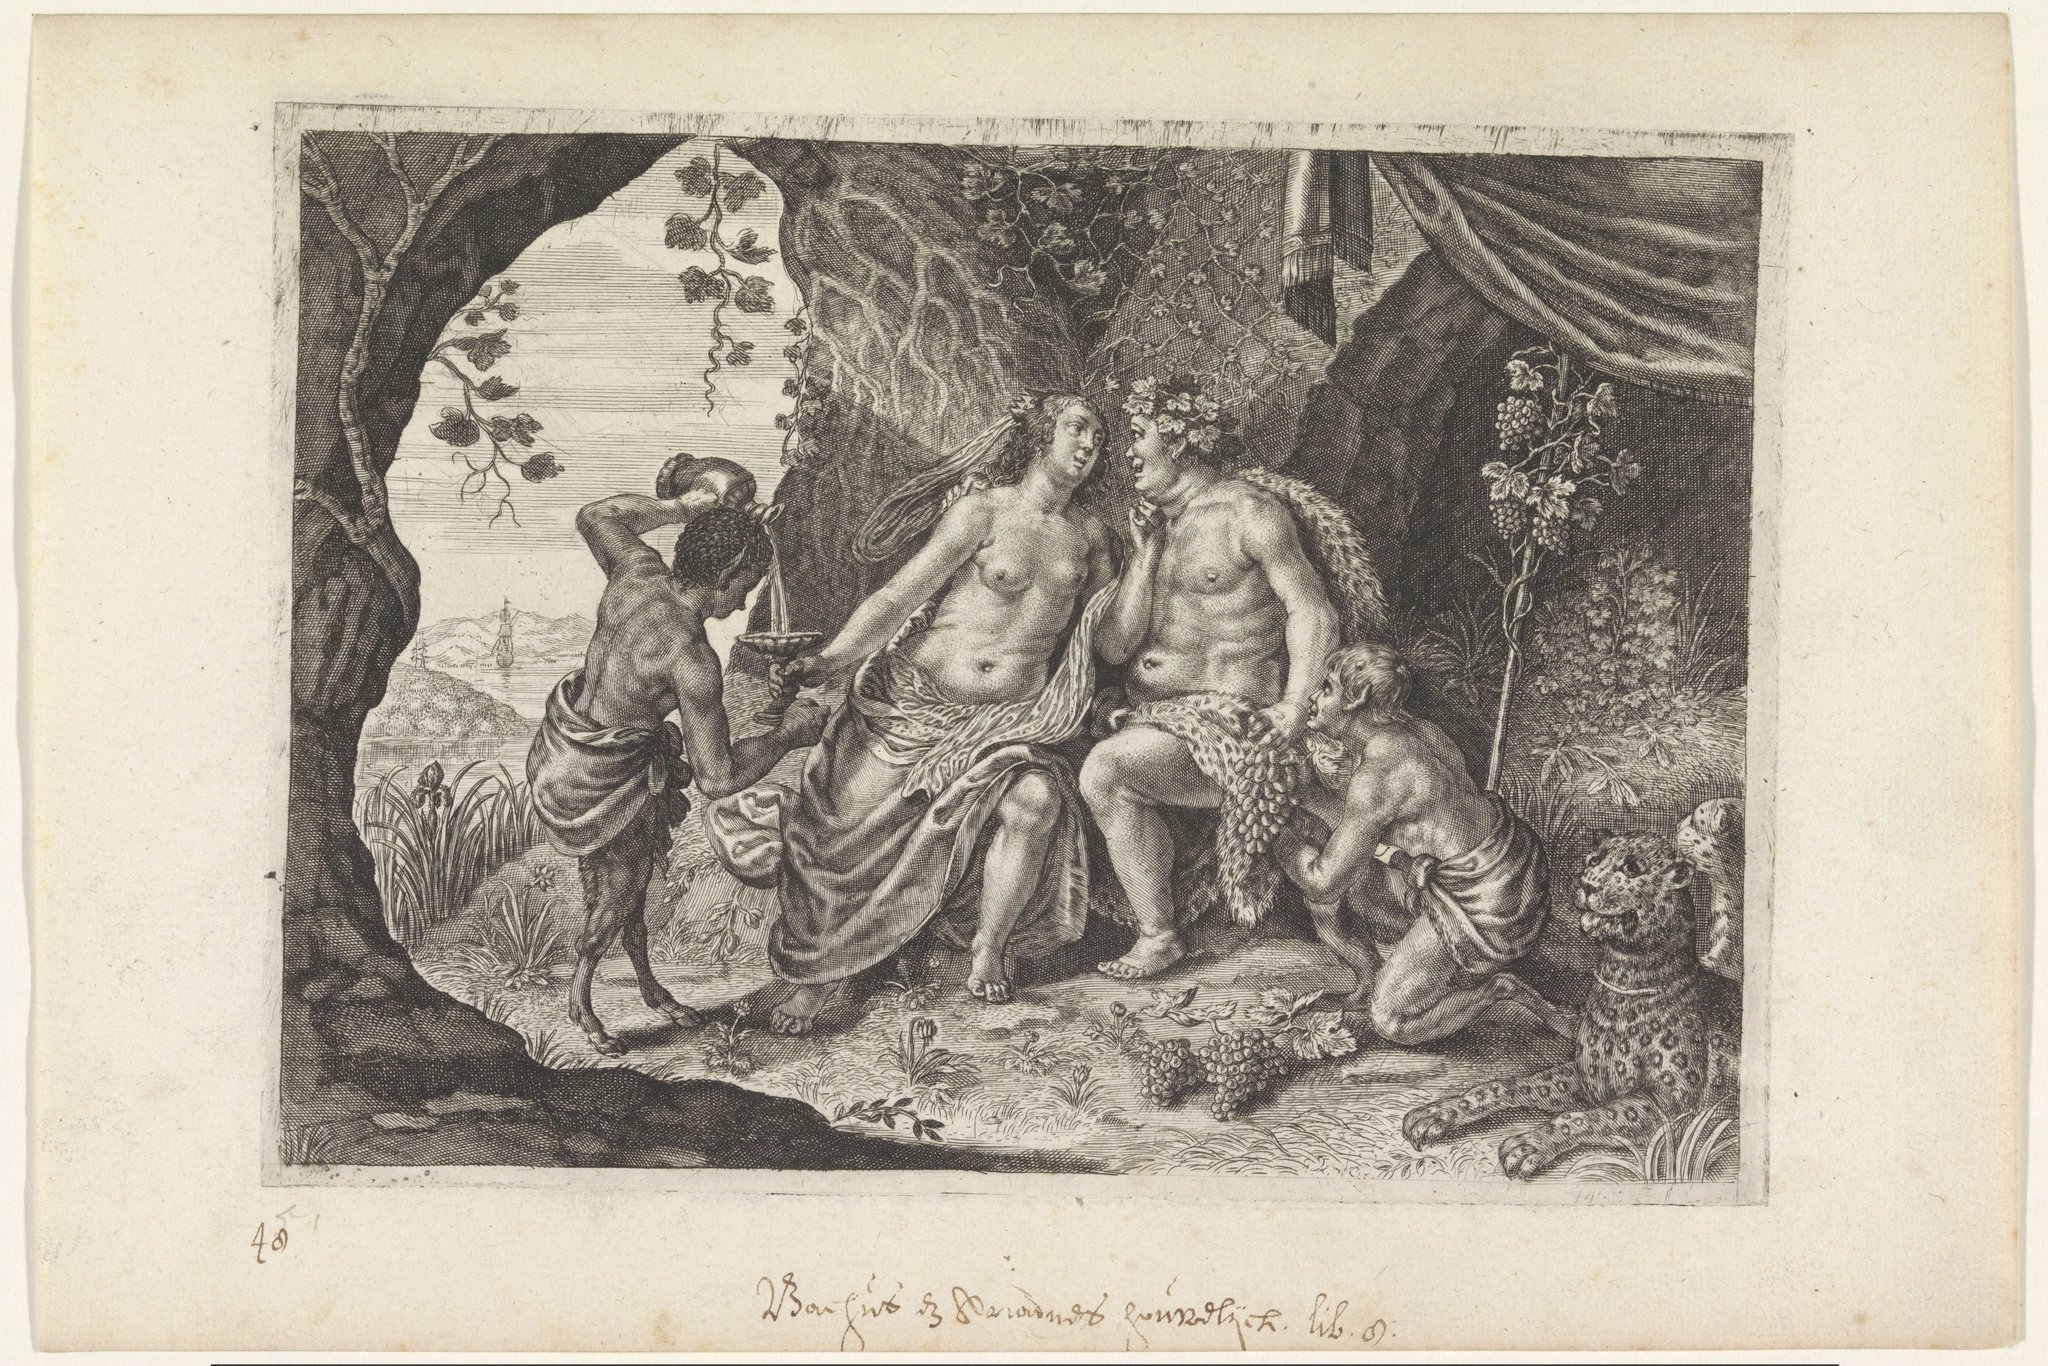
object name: print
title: The Marriage of Bacchus and Ariadne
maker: magdalena van de passe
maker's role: print maker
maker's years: 1600-1638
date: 1636-1670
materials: paper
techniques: engraving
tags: wedding of bacchus and ariadne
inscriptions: collector's mark: ‘Hinloopen’, annotation: ‘Bachus en Ariadnes houwelijck. lib. 8.’, number: ‘48’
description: Bacchus, the god of wine, and his wife Ariadne here drink to their marriage. Magdalena de Passe situated the newlyweds in a cave, where vines meander along the walls. The unfinished proof, above, affords insight into the engraver’s working process: she elaborated the background – the view from the cave – and the figures’ hands only in the final stage.